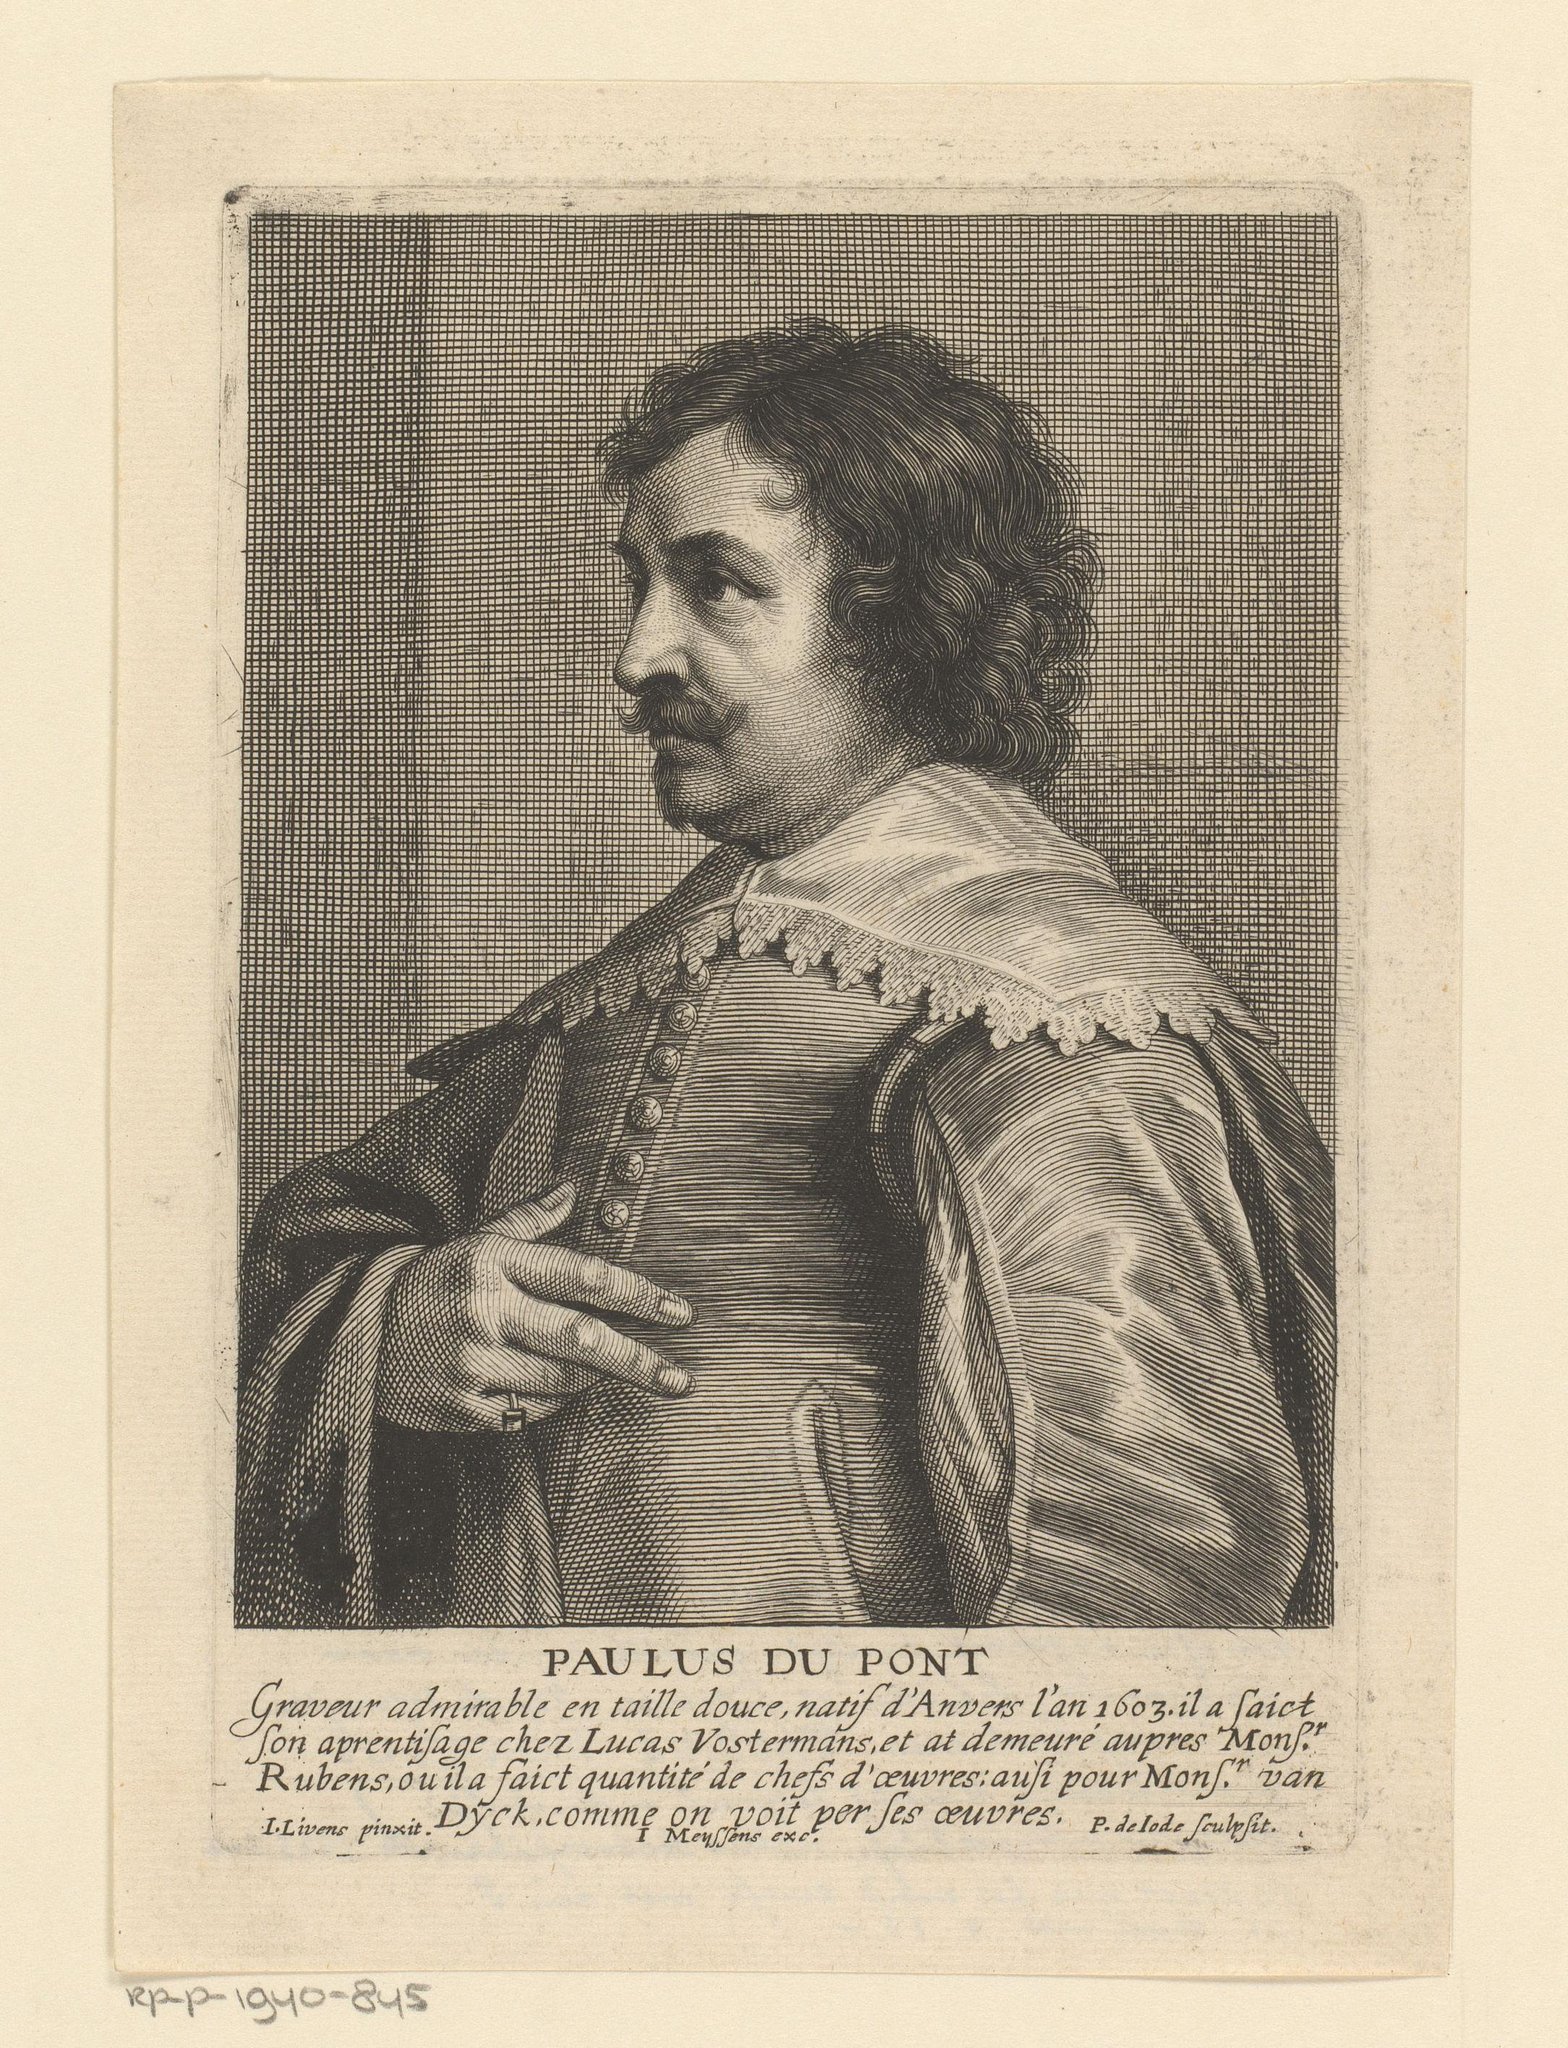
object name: print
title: Portret van Paulus Pontius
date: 1627-1670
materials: paper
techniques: engraving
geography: antwerp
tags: antwerp, print maker, draughtsman, paulus pontius, historical persons, portrait, self-portrait of artist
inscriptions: inscription: ‘Hiervan bestaat een (...) met 2 55. -’, collector's mark: Lugt 2760, collector's mark: Lugt 2228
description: Met vierregelig onderschrift in het Frans.